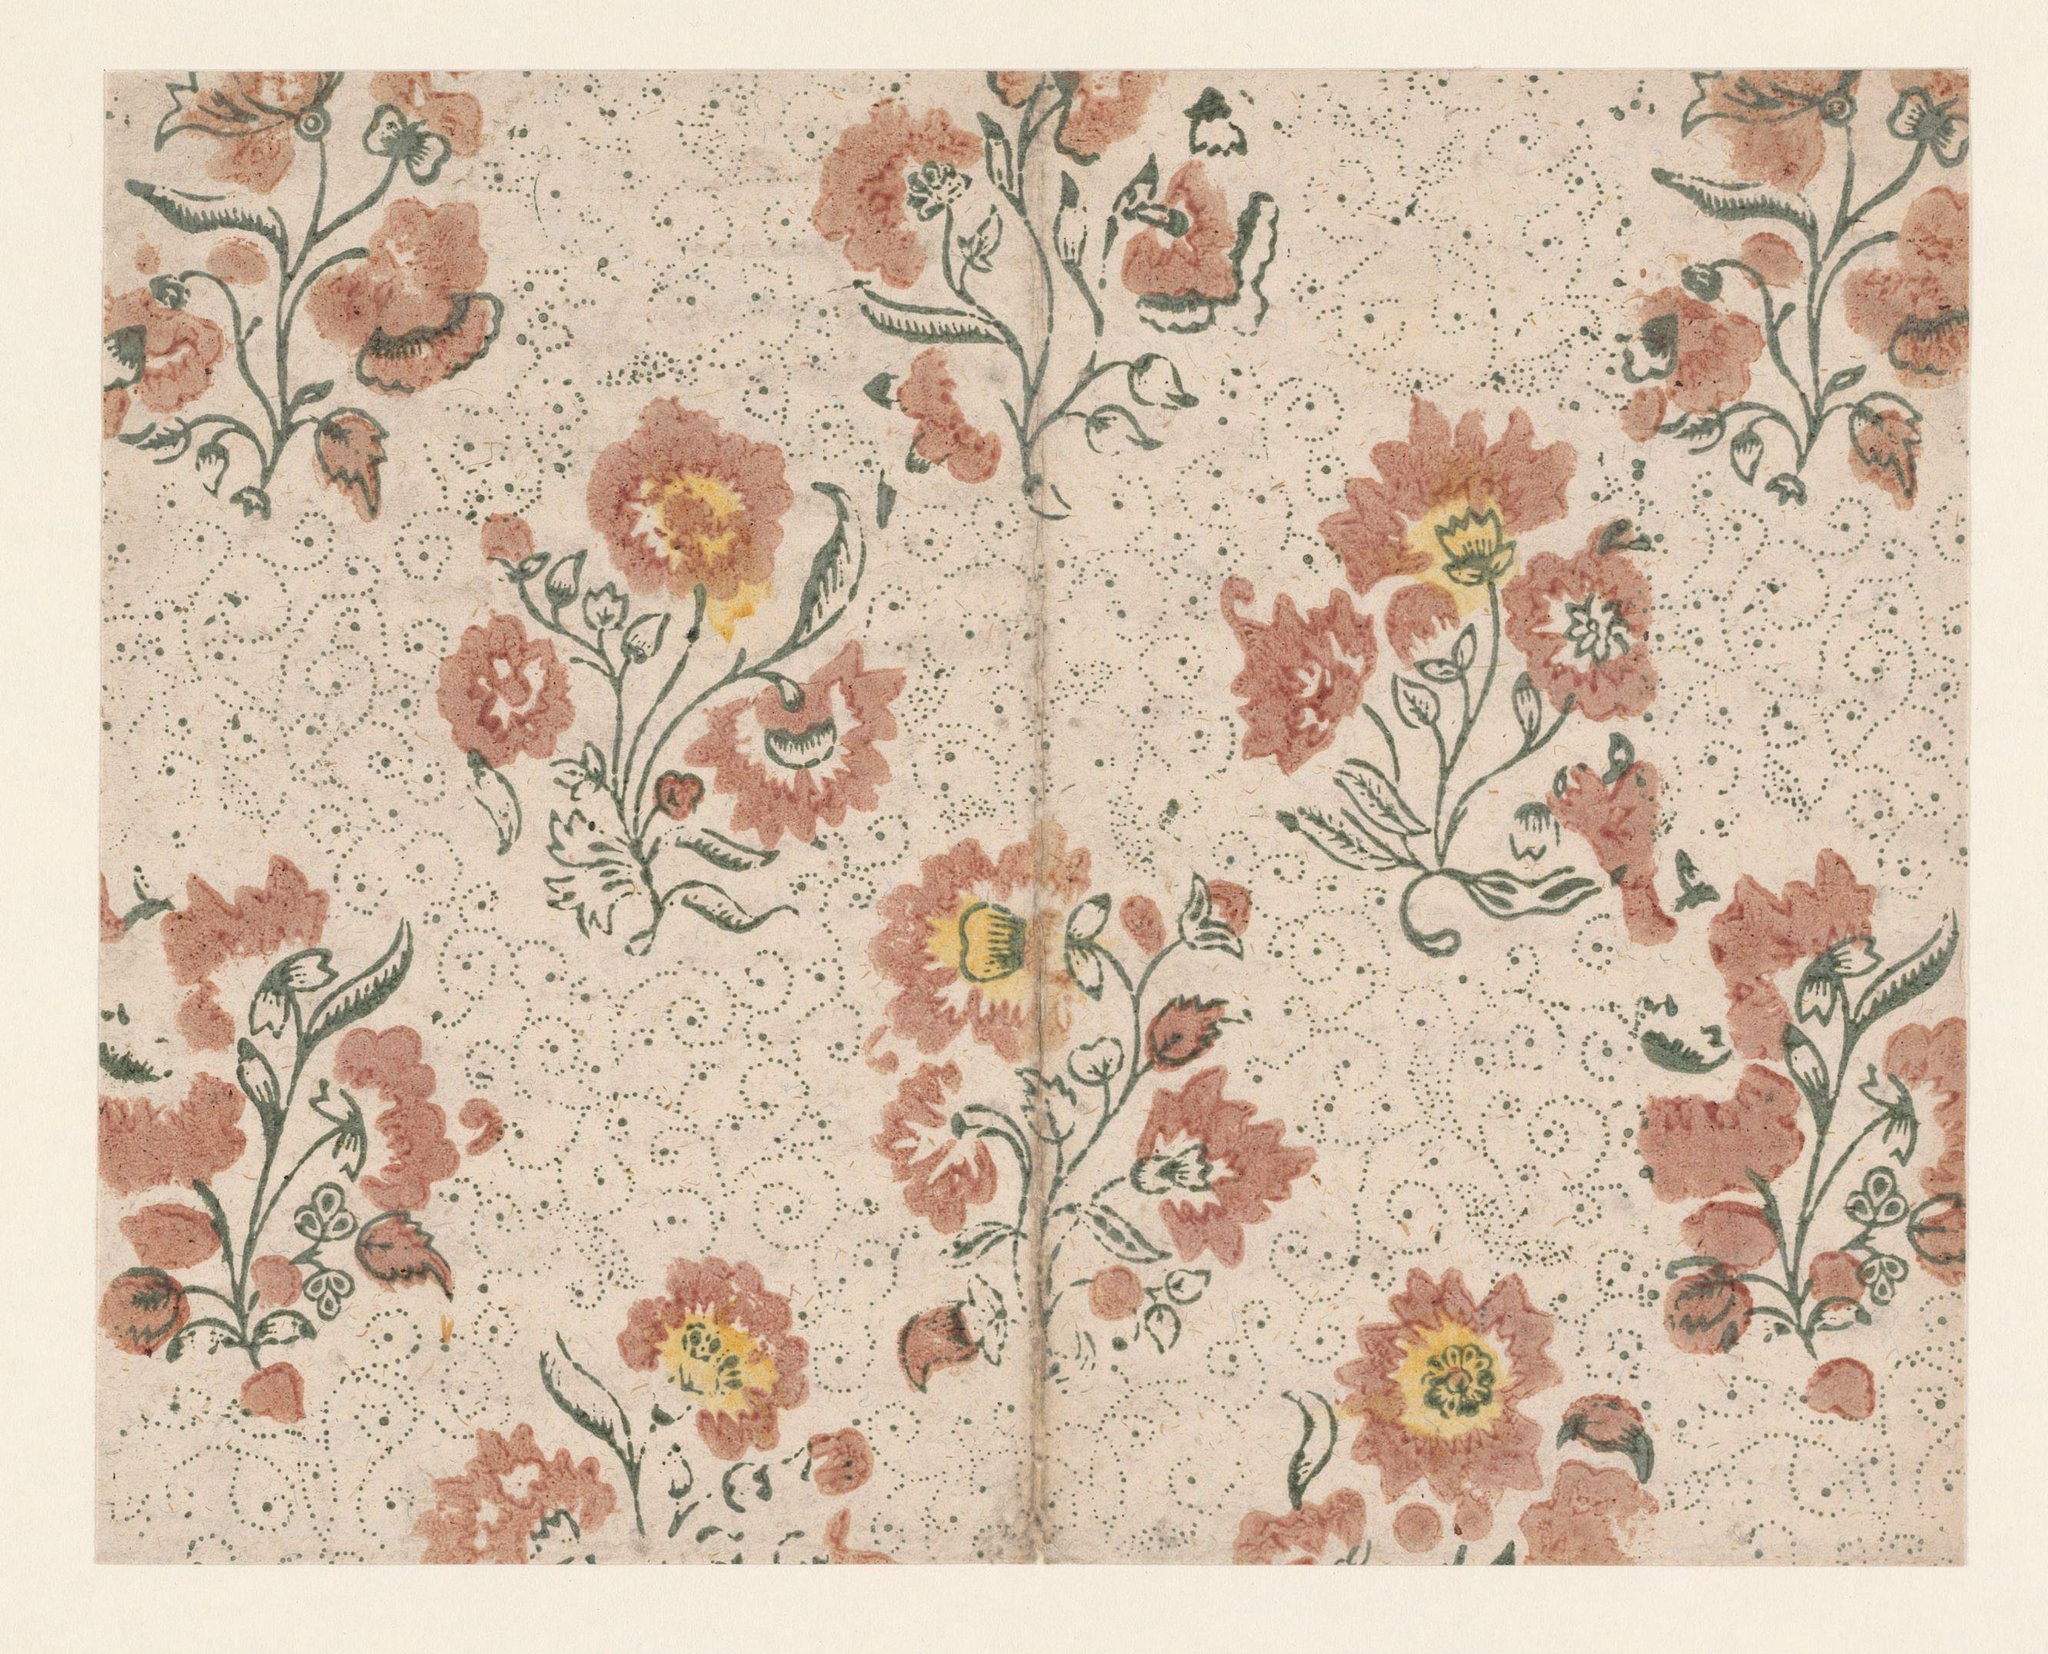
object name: wrapper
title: Blad met strooipatroon van bloemen op fond van stippellijnen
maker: Anonymous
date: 1755-1795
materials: paper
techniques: printing block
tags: ornament derived from plant forms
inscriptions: annotation: ‘Aanspraak Leid. 1777’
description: Blad met strooipatroon van bloemenranken op een fond van krullende stippellijnen. Gebruikt als omslag voor een publicatie uit 1777.